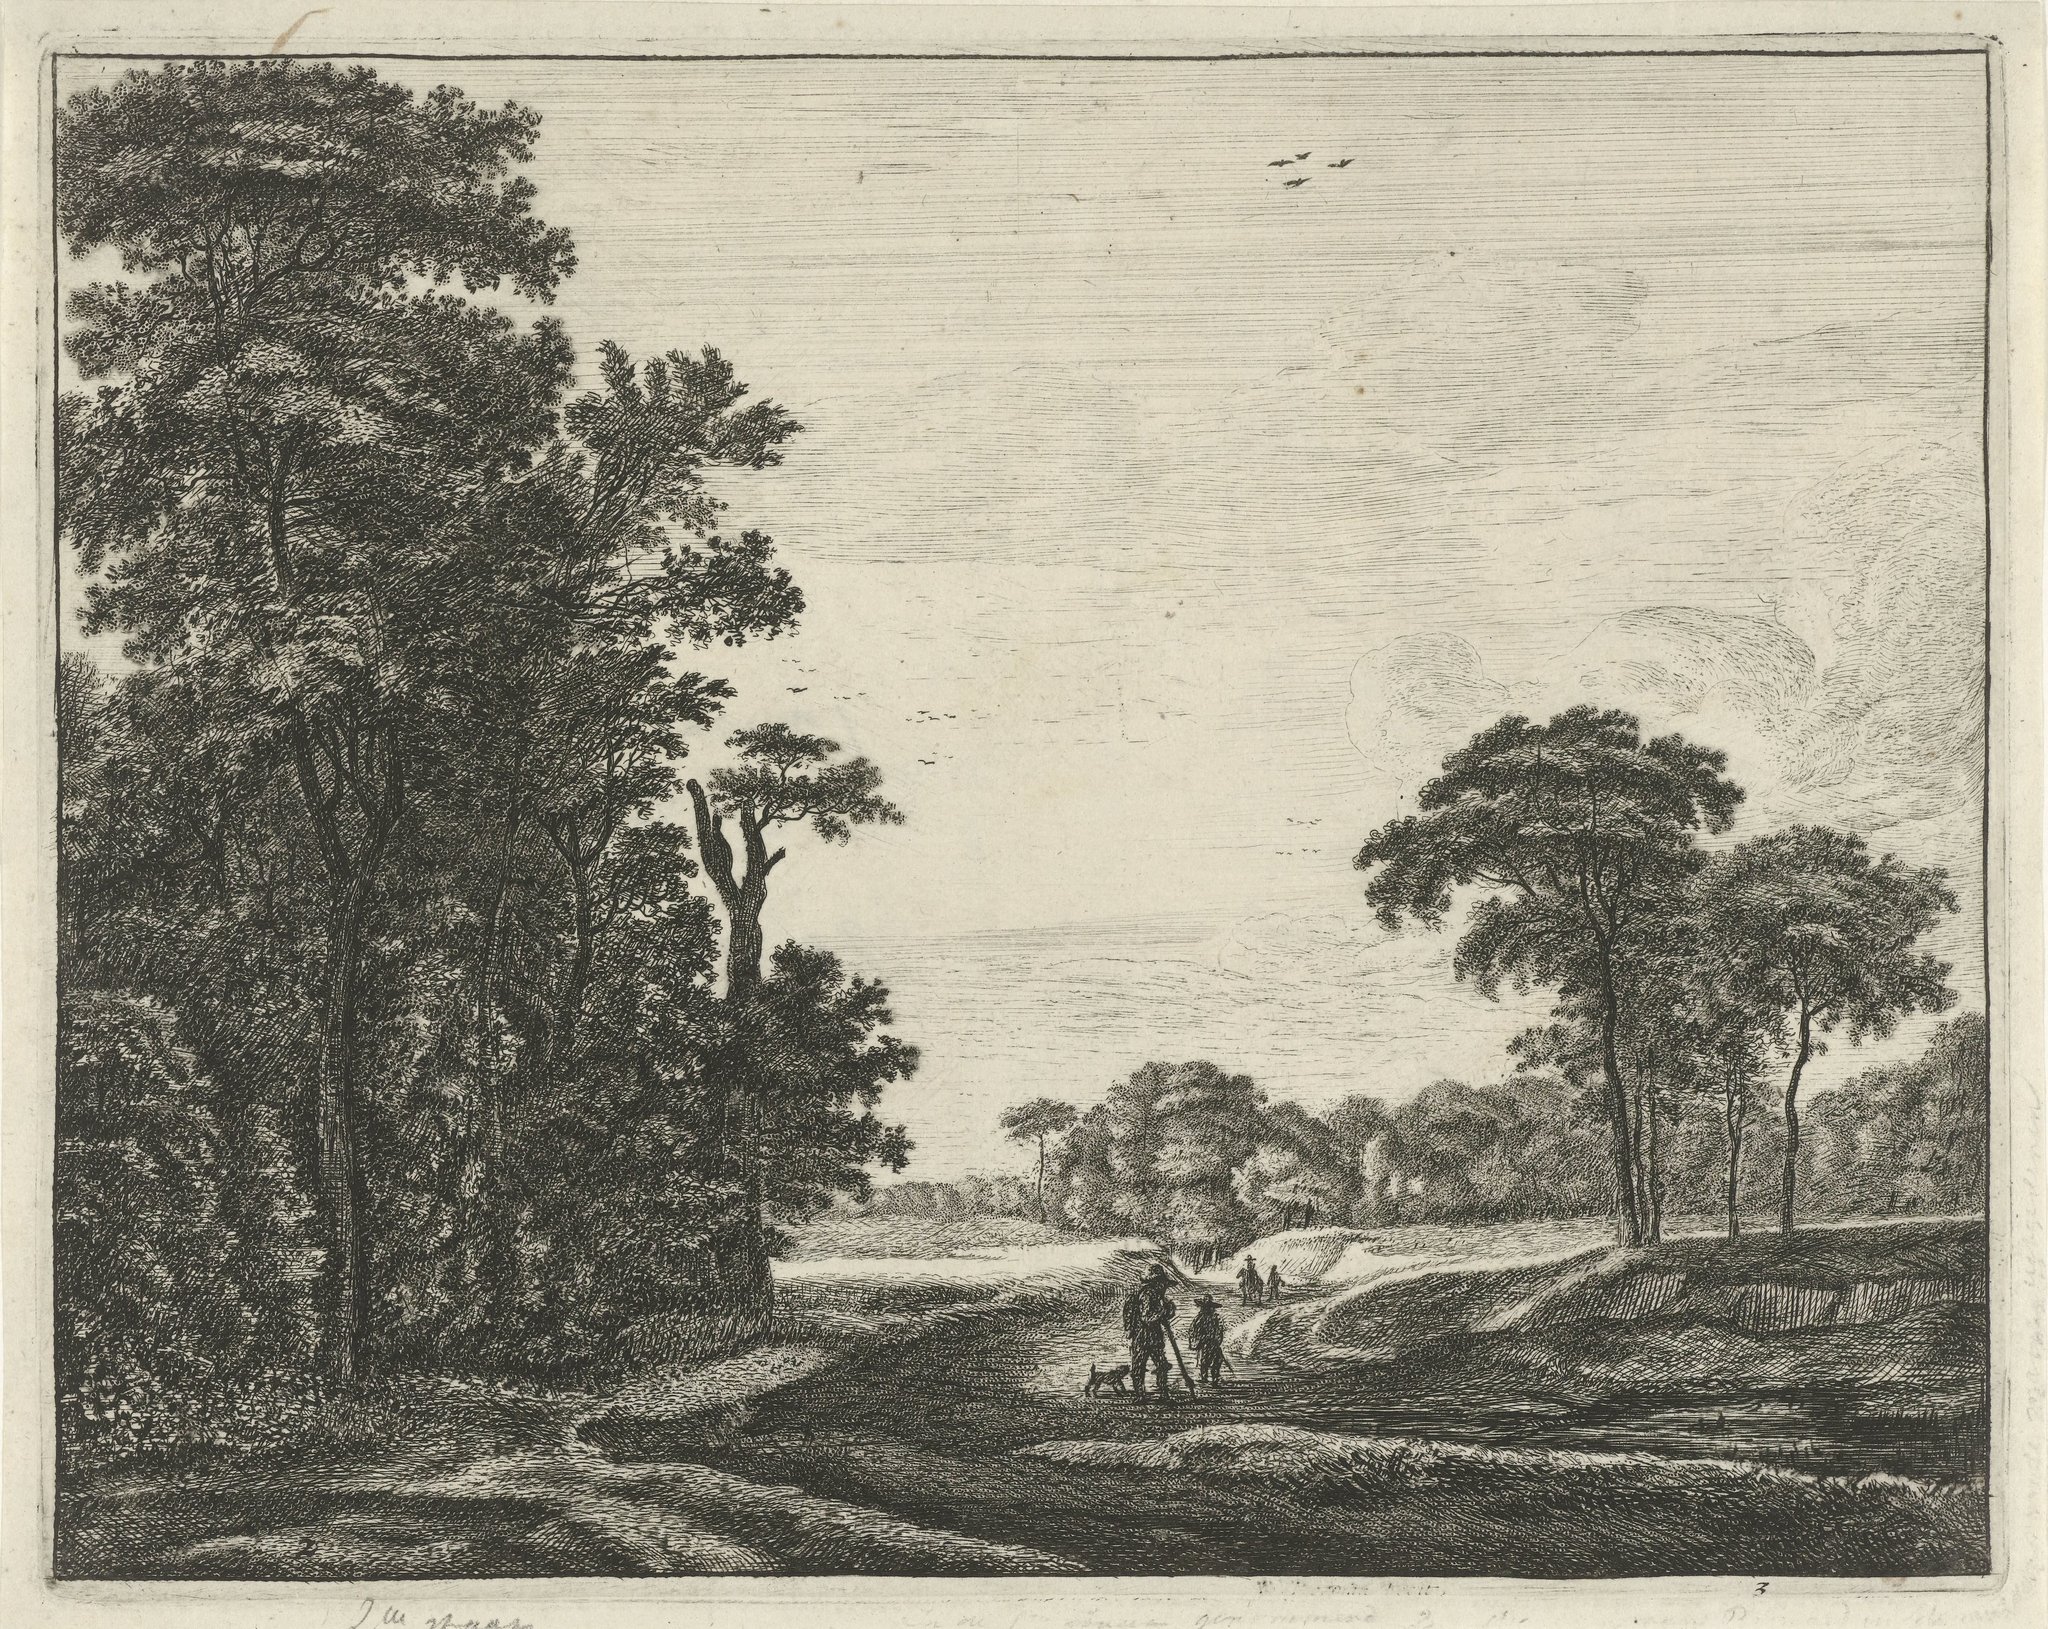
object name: print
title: Pad aan de rand van het Haagse Bos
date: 1637-1652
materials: paper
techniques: etching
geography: amsterdam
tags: forest, wood, forest path or lane, 'en route', traveller under way, dog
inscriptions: collector's mark: Lugt 240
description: Op een pad, aan de rand van het Haagse Bos, lopen enkele wandelaars en een hond.